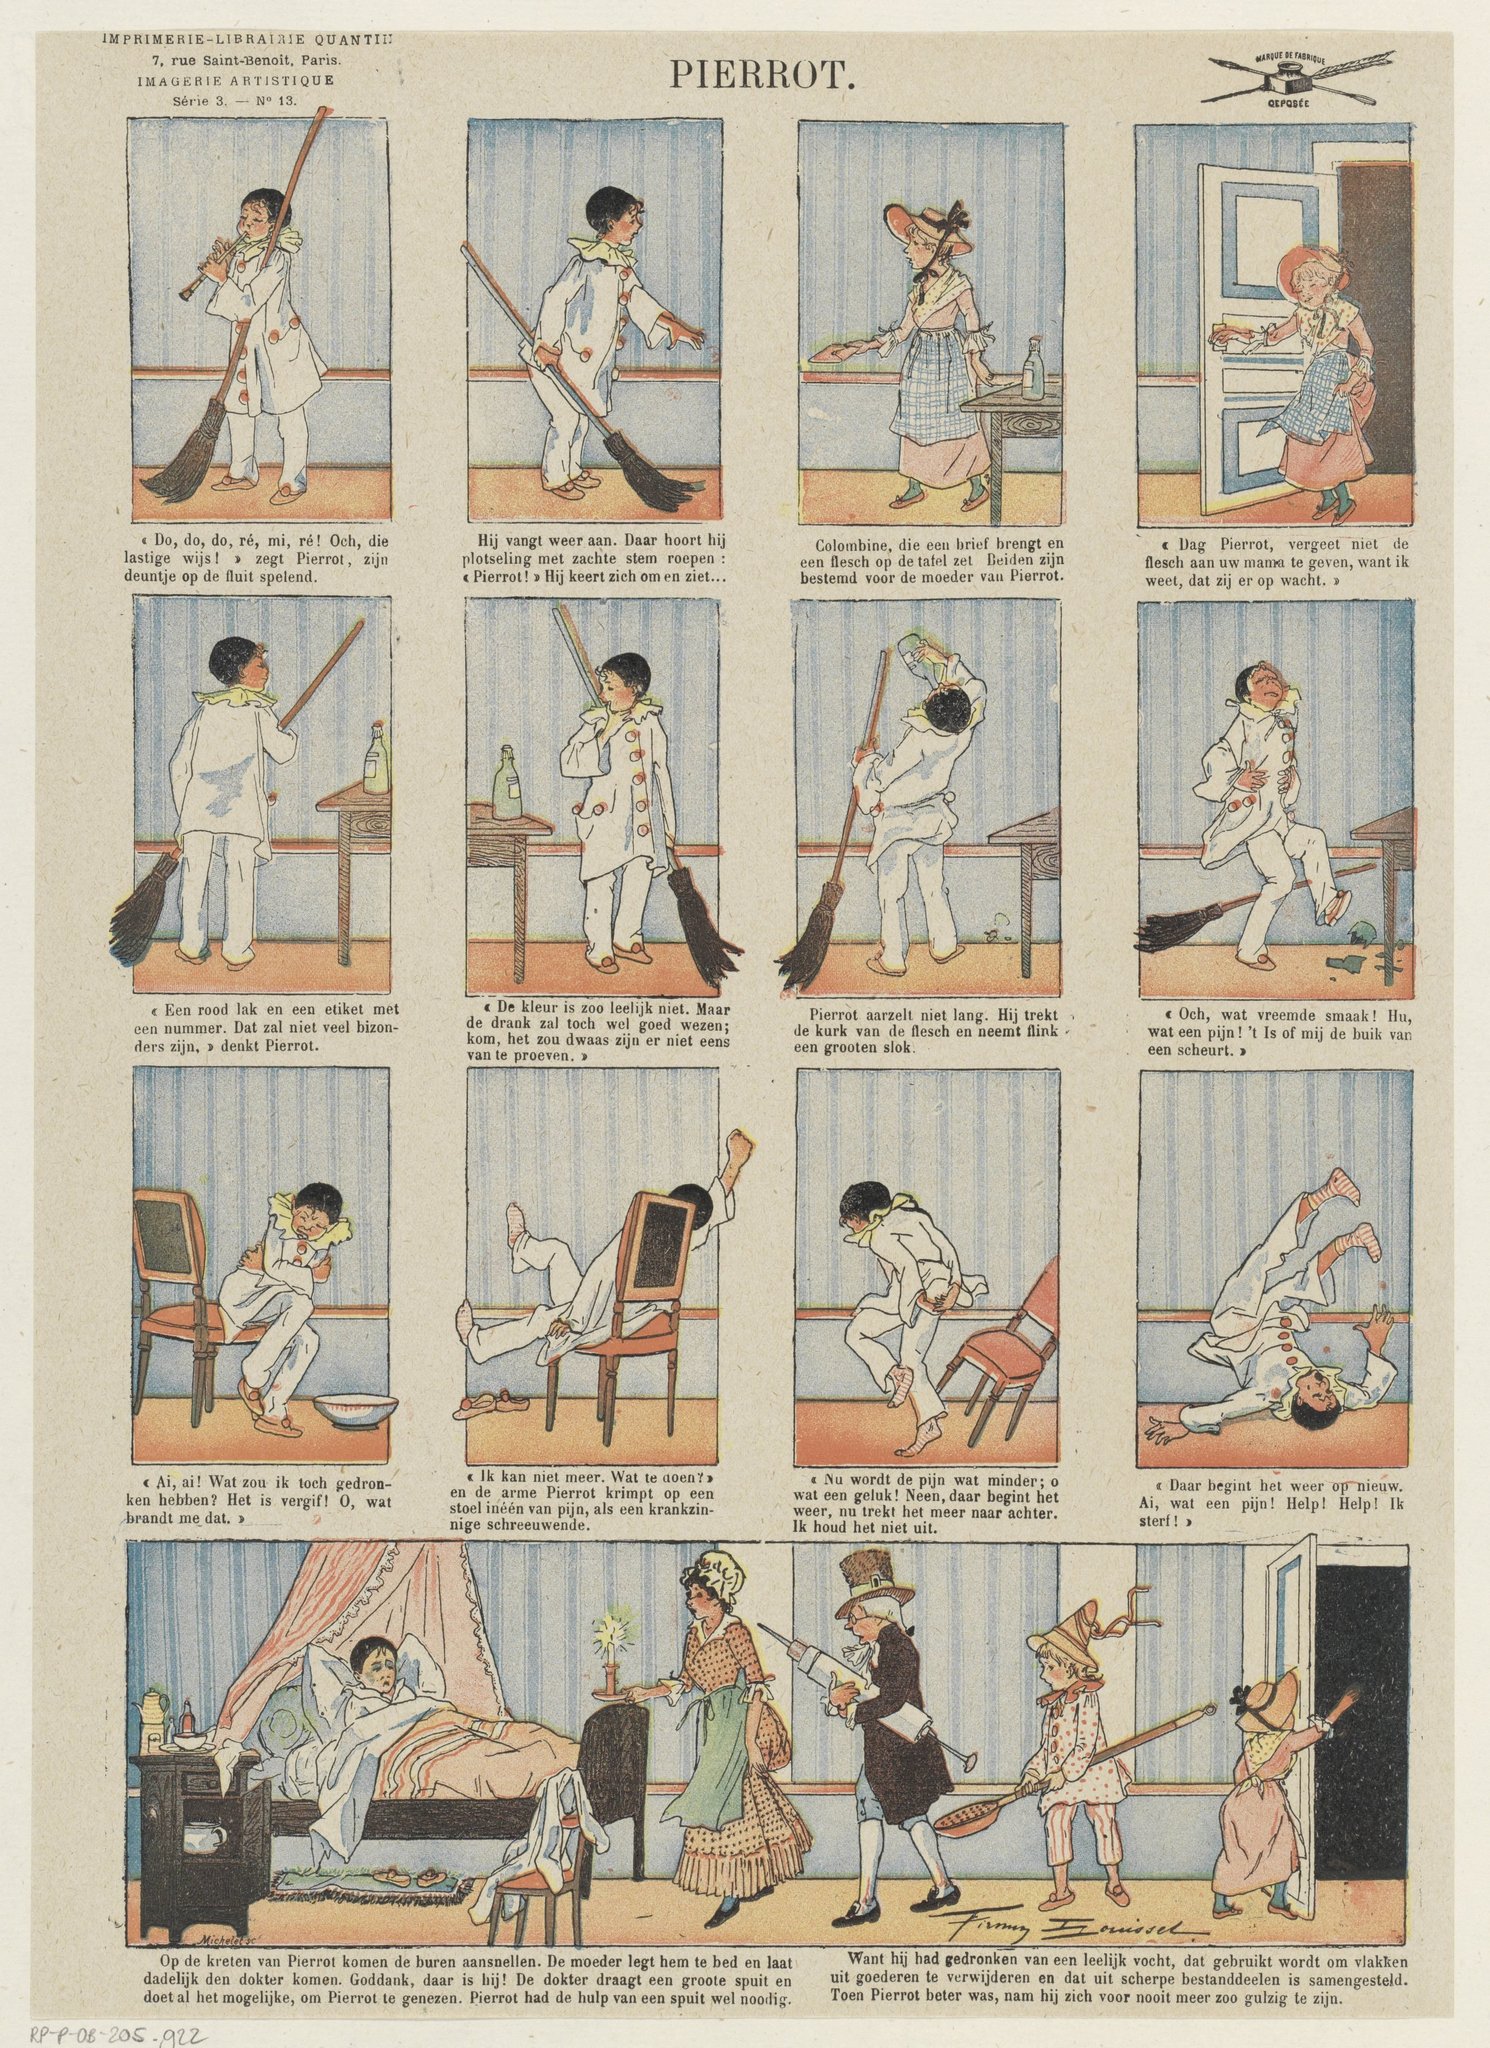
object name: popular print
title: Pierrot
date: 1876-1890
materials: paper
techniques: lithograph, letterpress printing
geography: paris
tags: types in 'commedia dell'arte': pierrot, sick-bed, patient, sick person, tales and fairy tales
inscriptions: : ‘marque de fabrique / deposée’, collector's mark: Lugt 2760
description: Blad met 13 voorstellingen van Pierrot die ziek wordt na het drinken van schoonmaakmiddel. Onder elke voorstelling een onderschrift. Genummerd linksboven: Série 3. - No. 13.